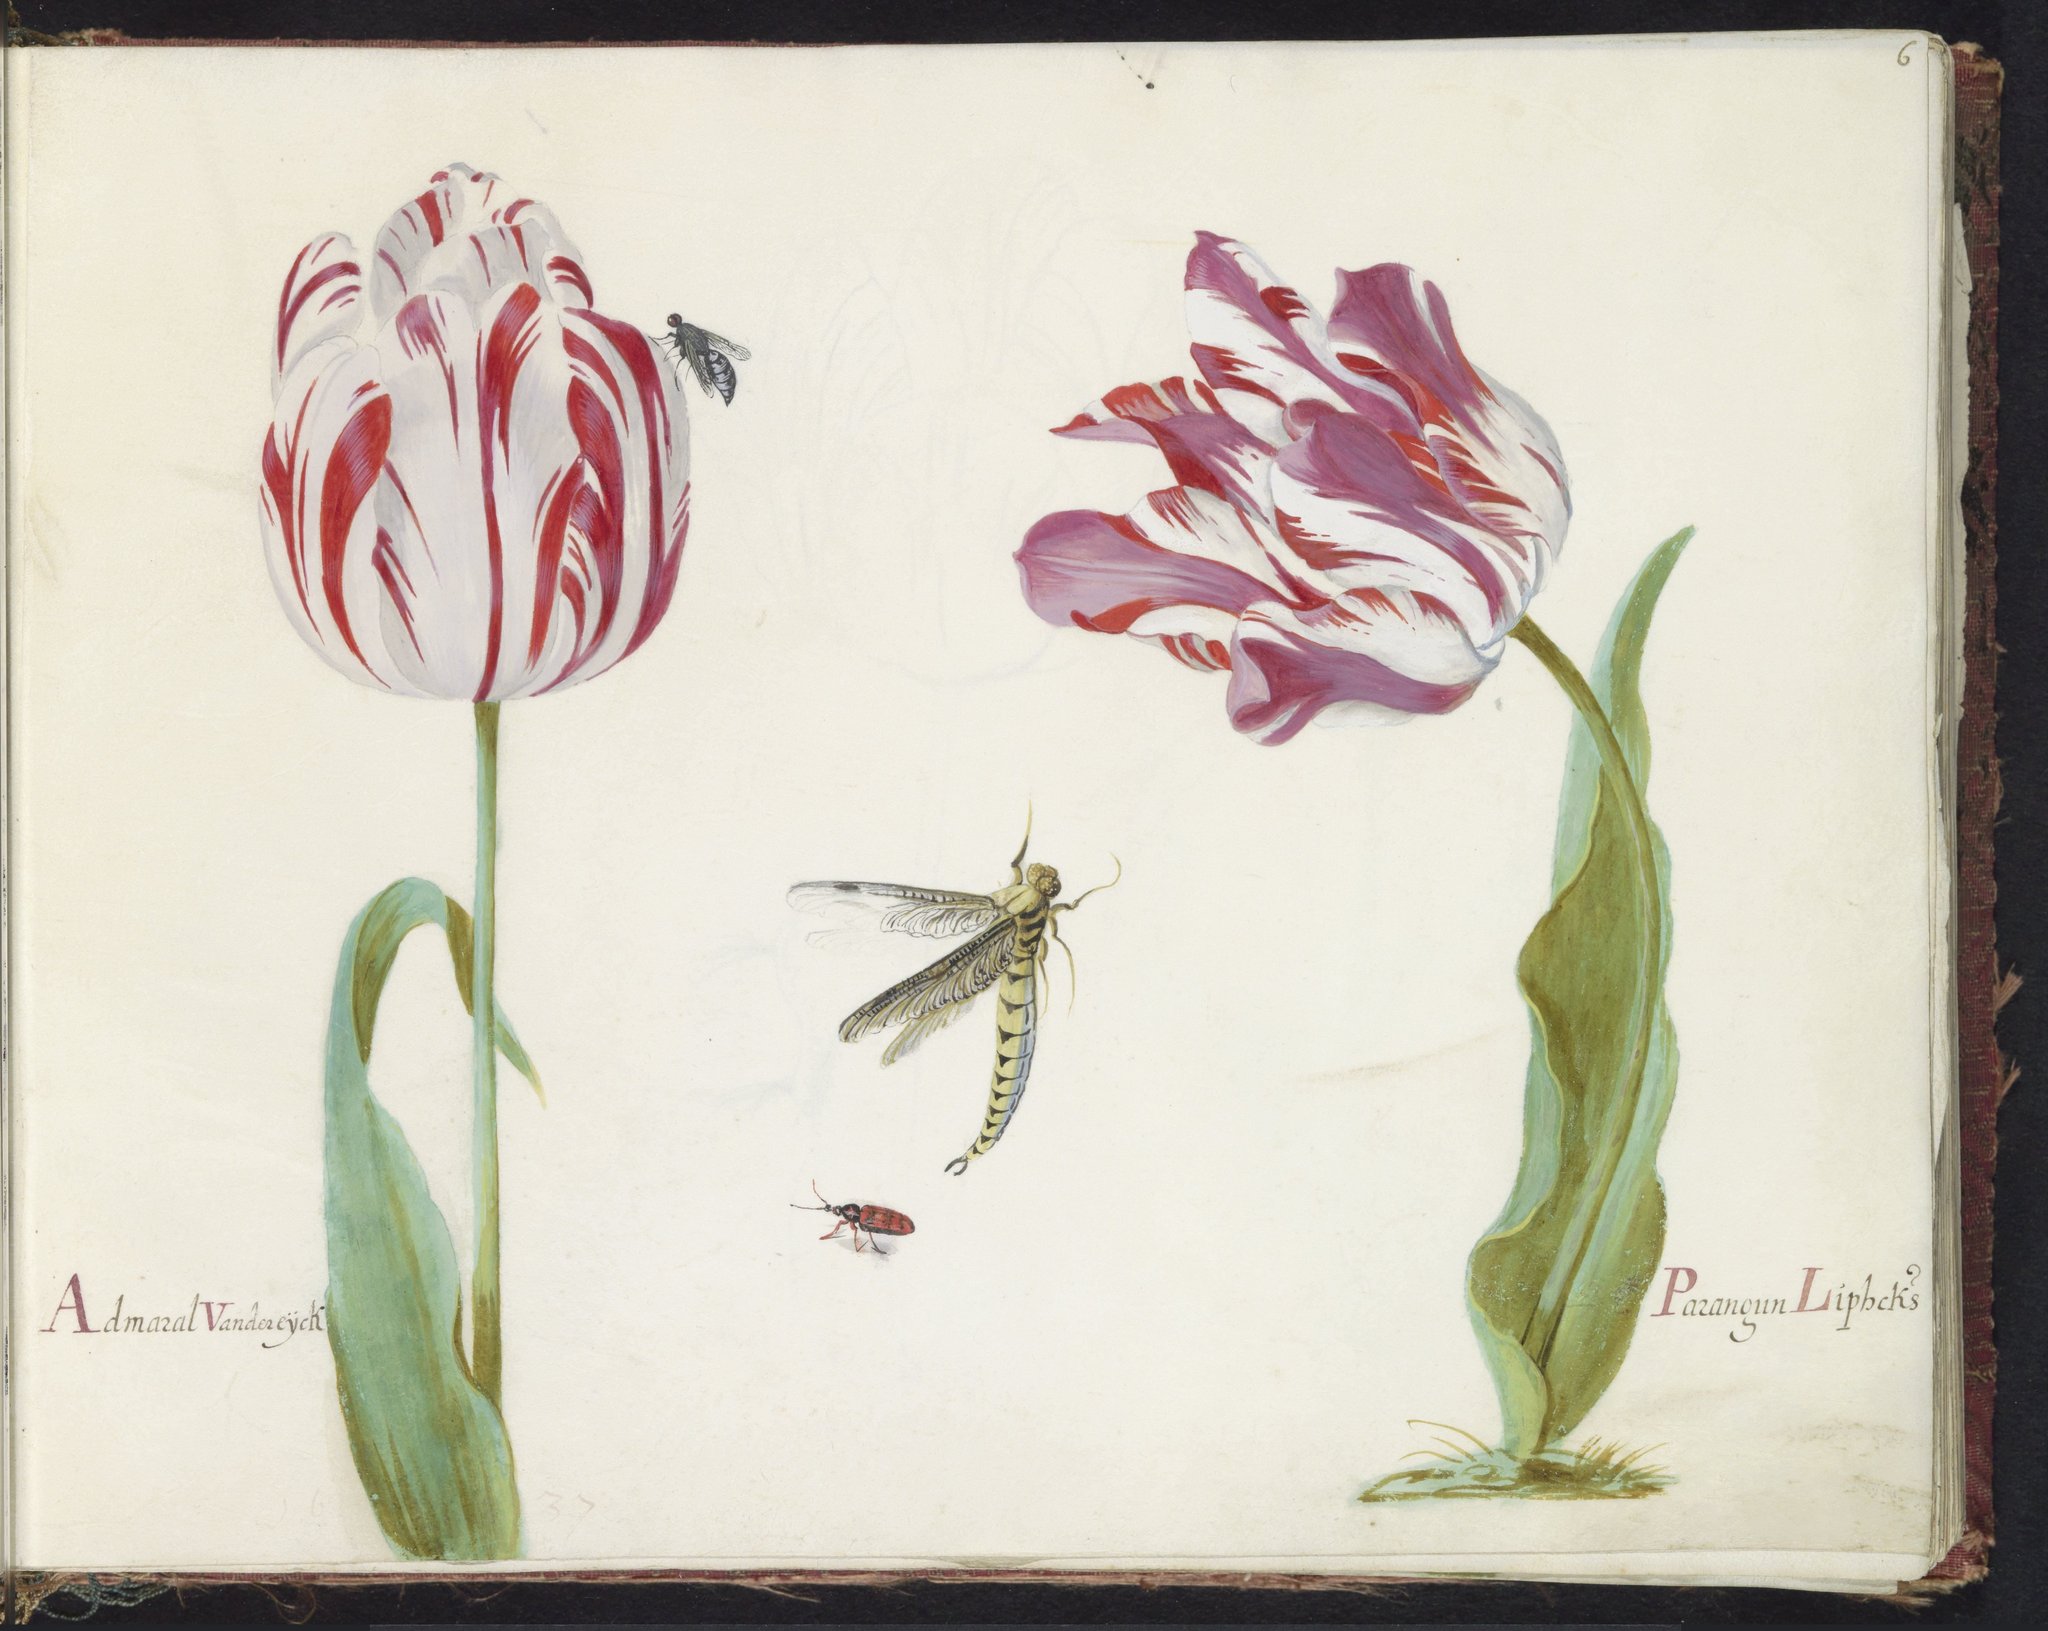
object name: drawing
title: Admaral Vanden eijck / Parangun Liphcks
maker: jacob marrel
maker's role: draughtsman, painter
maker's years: 1614-1681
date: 1637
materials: paint, parchment, pencil, watercolor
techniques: brush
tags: insects: dragon-fly, flowers: tulip, insects: beetle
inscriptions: date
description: De tekening maakt deel uit van een album.